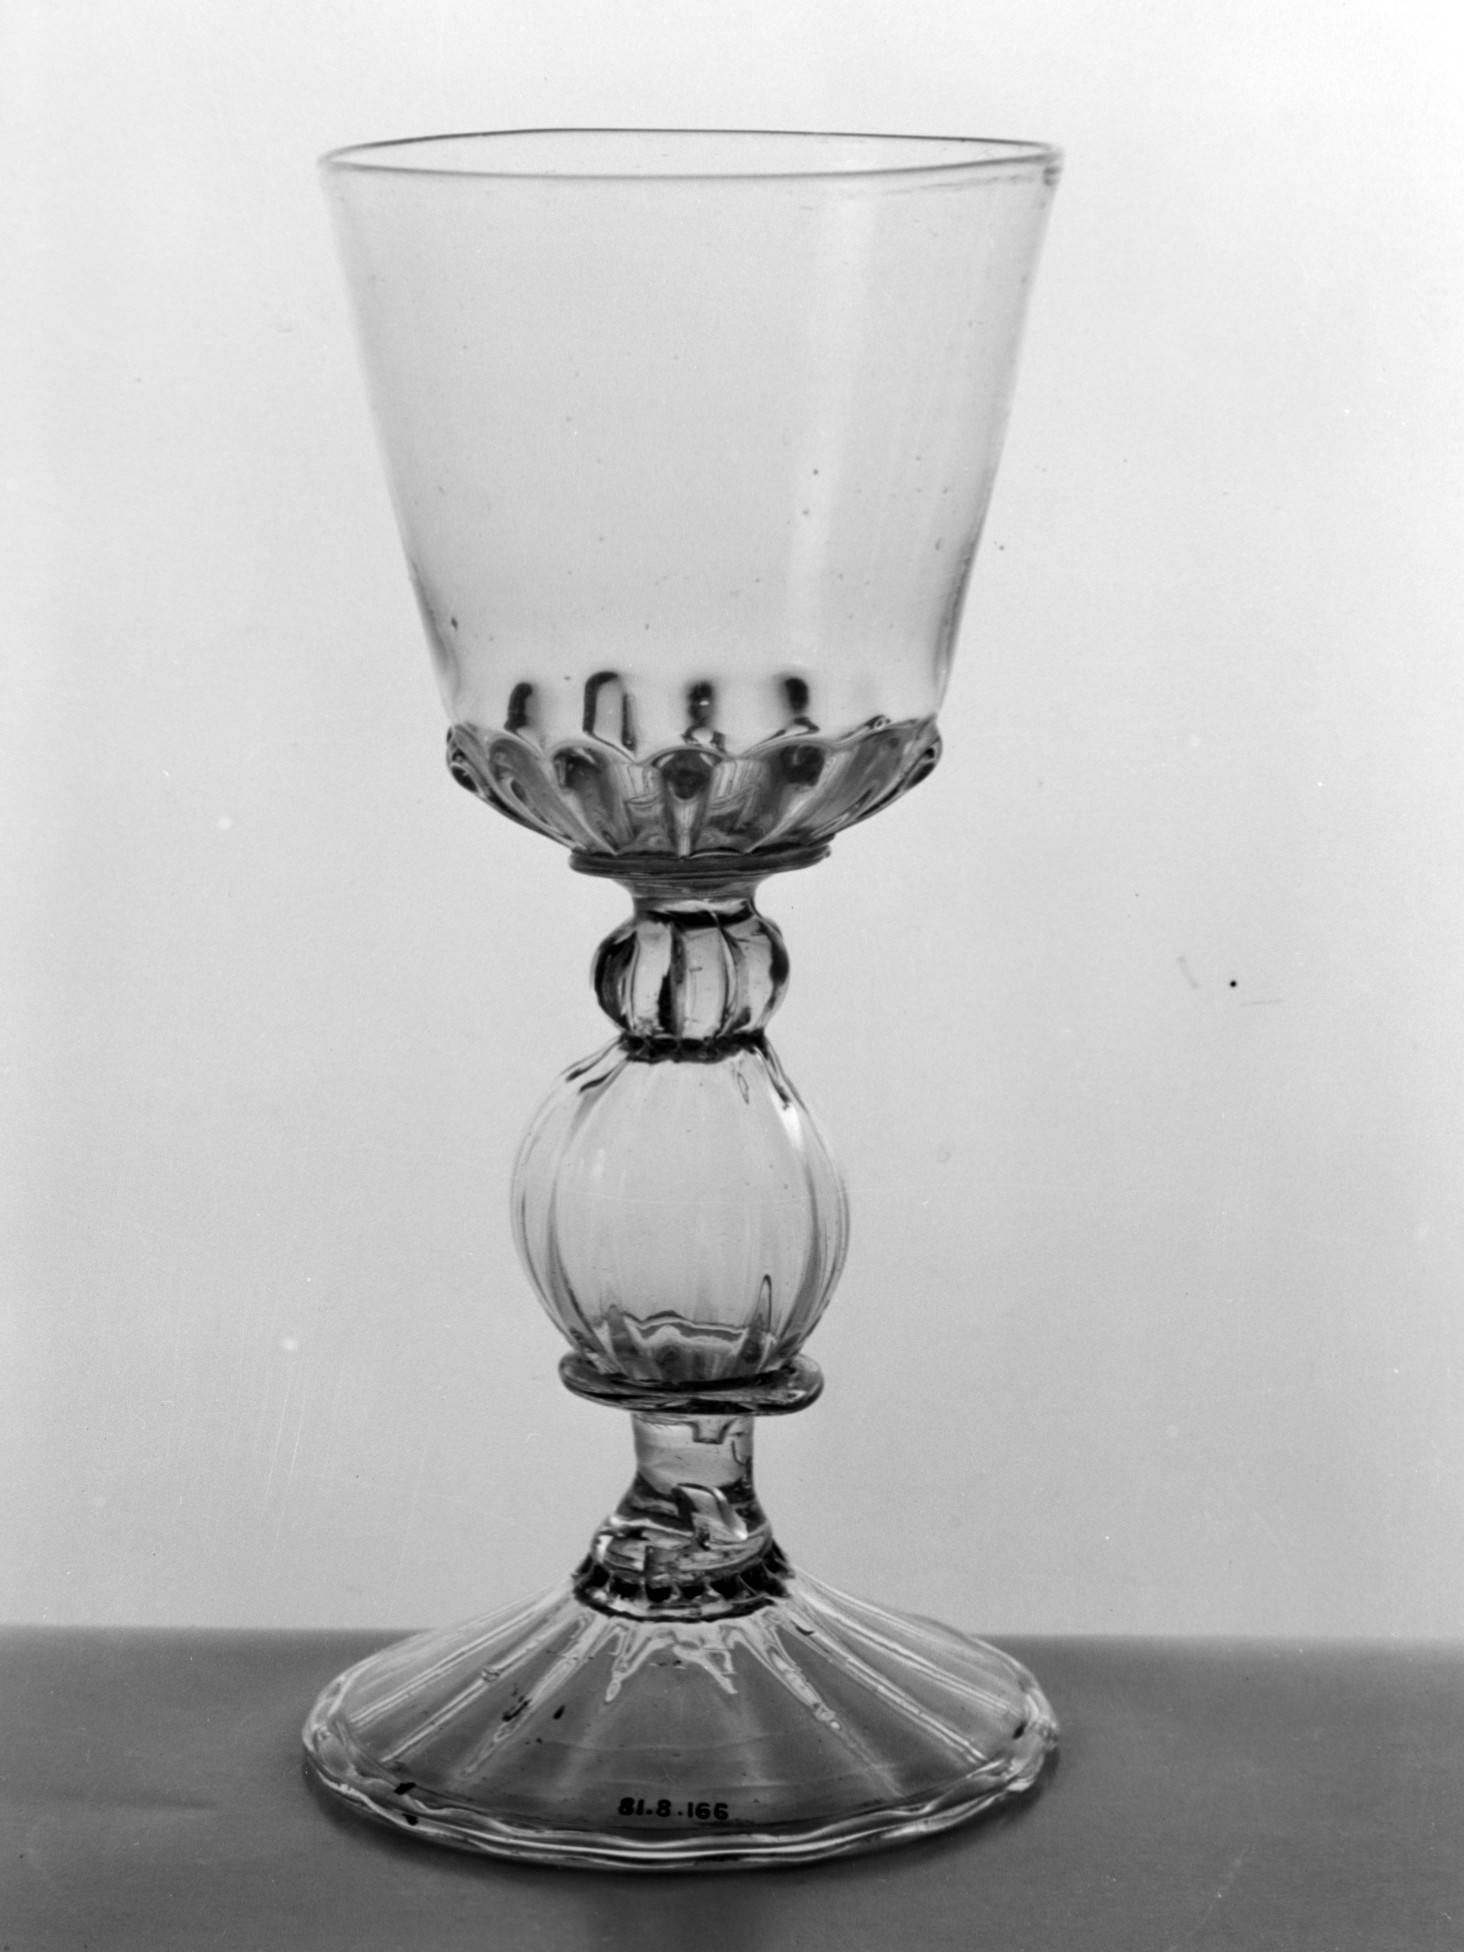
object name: goblet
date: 1667-1700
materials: glass